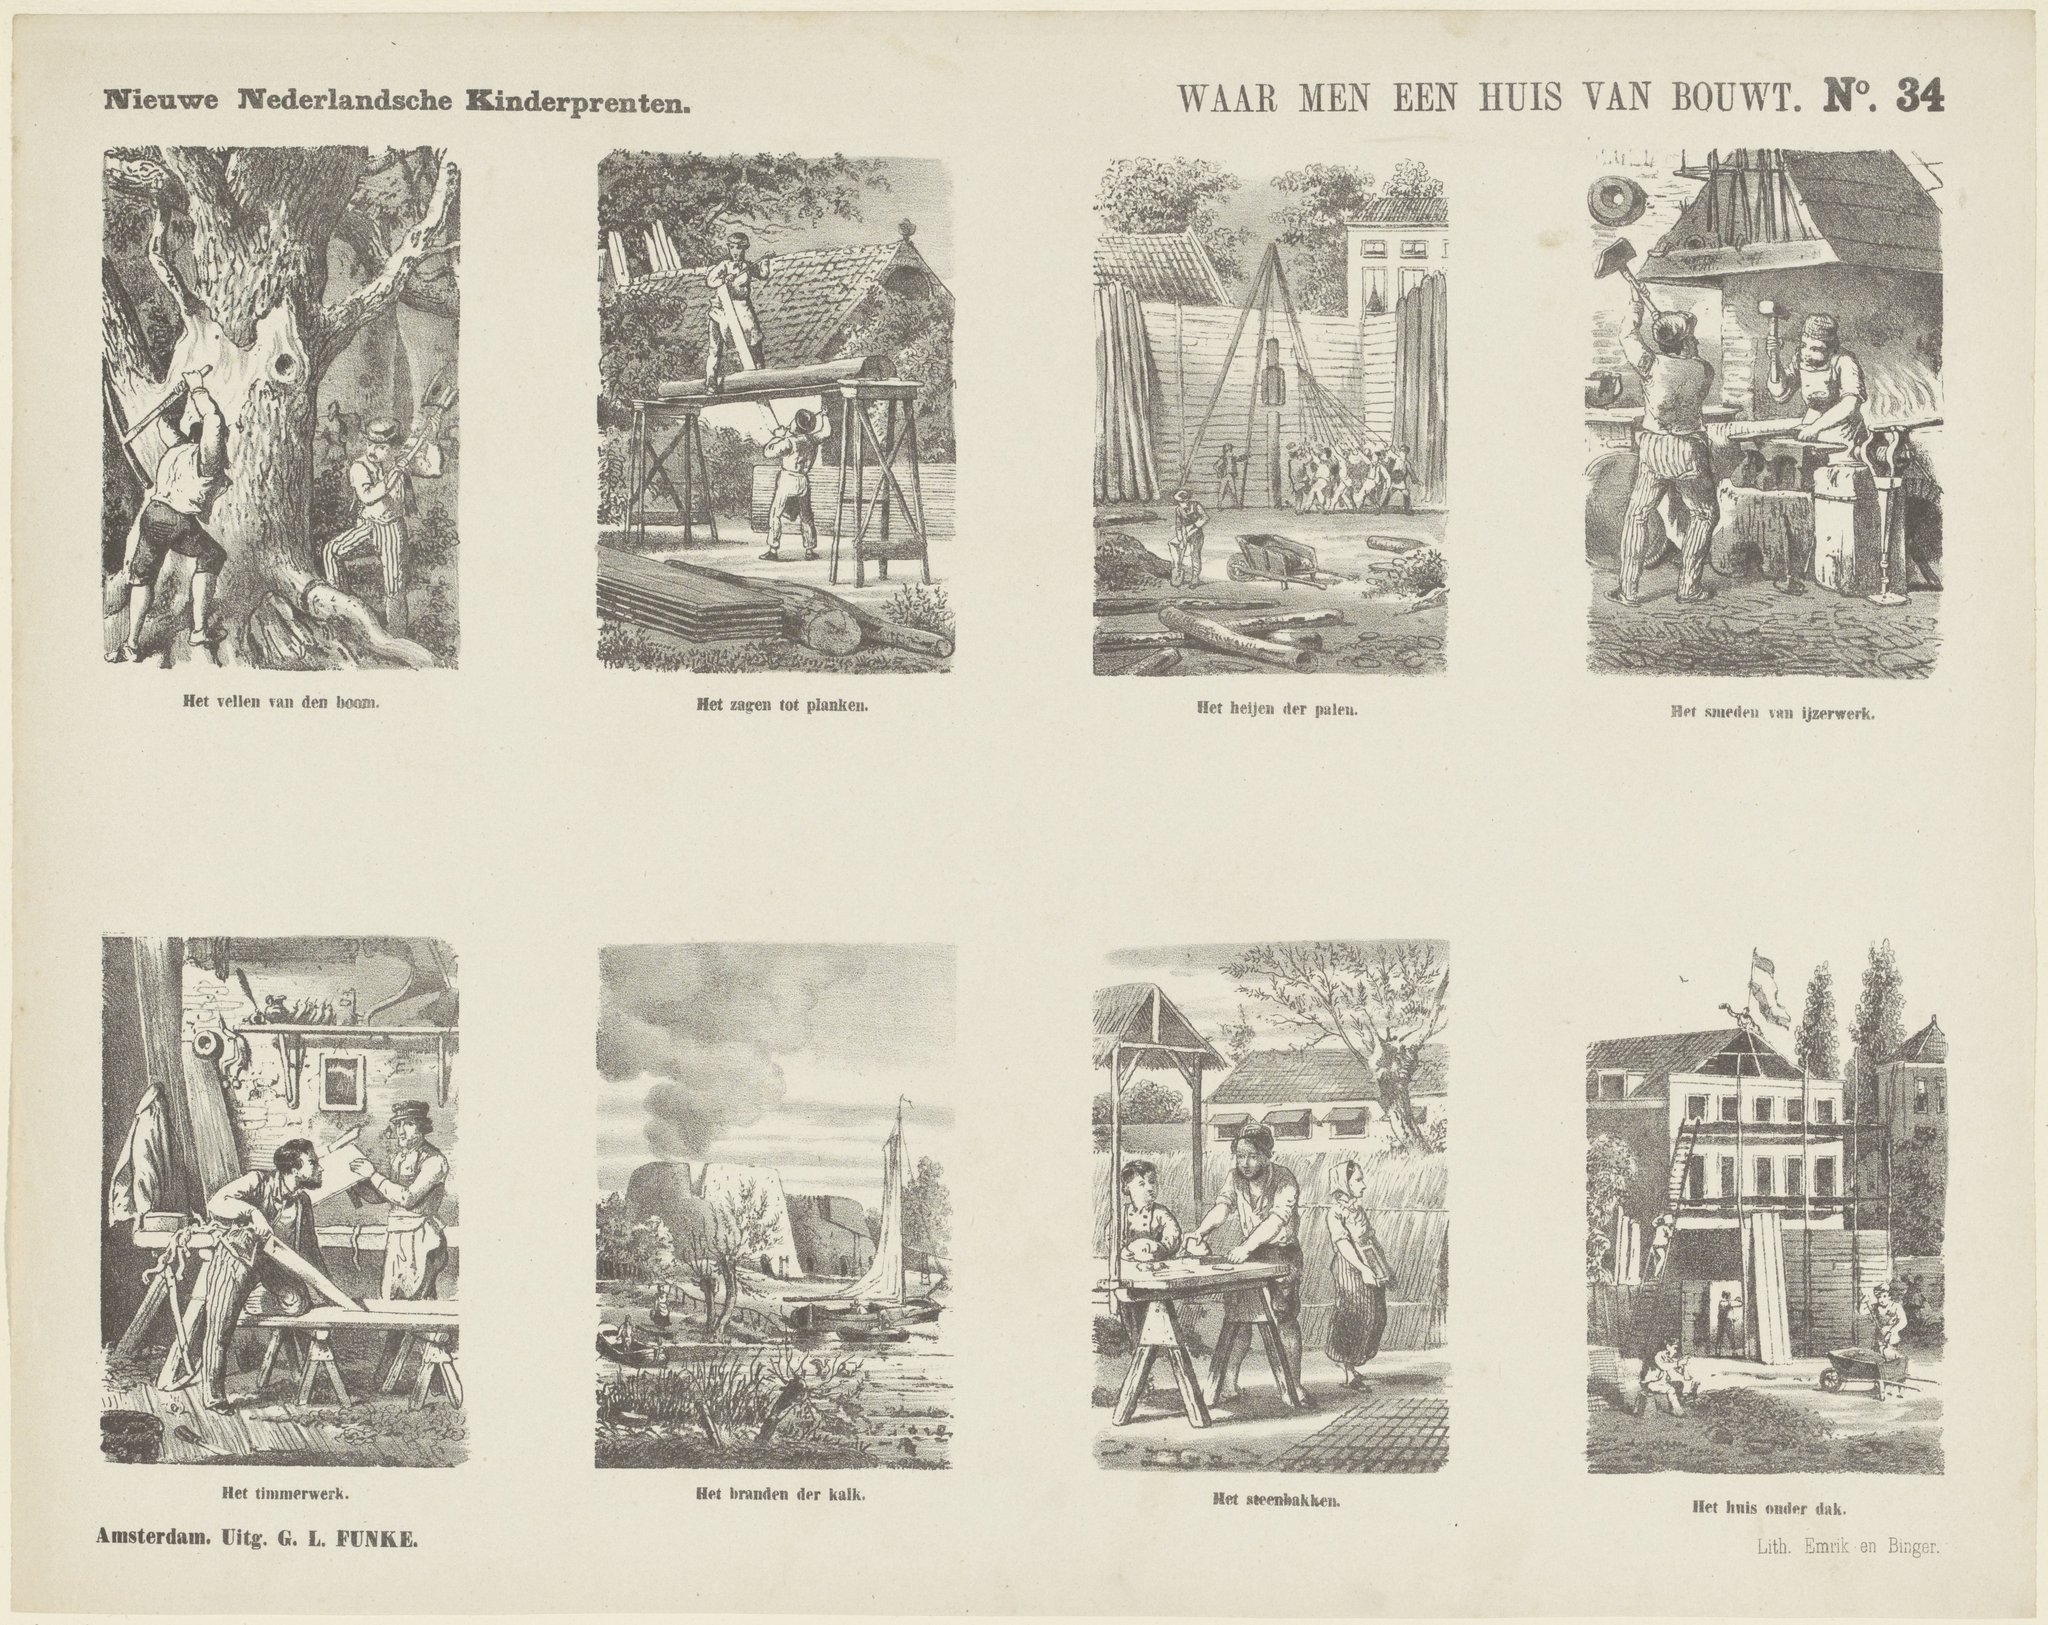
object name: popular print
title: Nieuwe Nederlandsche kinderprenten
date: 1865-1875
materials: paper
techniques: letterpress printing, lithograph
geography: haarlem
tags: roof (of house or building), building-site, sawing (industrial process)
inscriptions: collector's mark: Lugt 2760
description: Blad met 8 voorstellingen over het bouwen van een huis. Van het kappen van bomen tot aan het plaatsen van het dak. Onder elke afbeelding een onderschrift. Genummerd rechtsboven: No. 34.